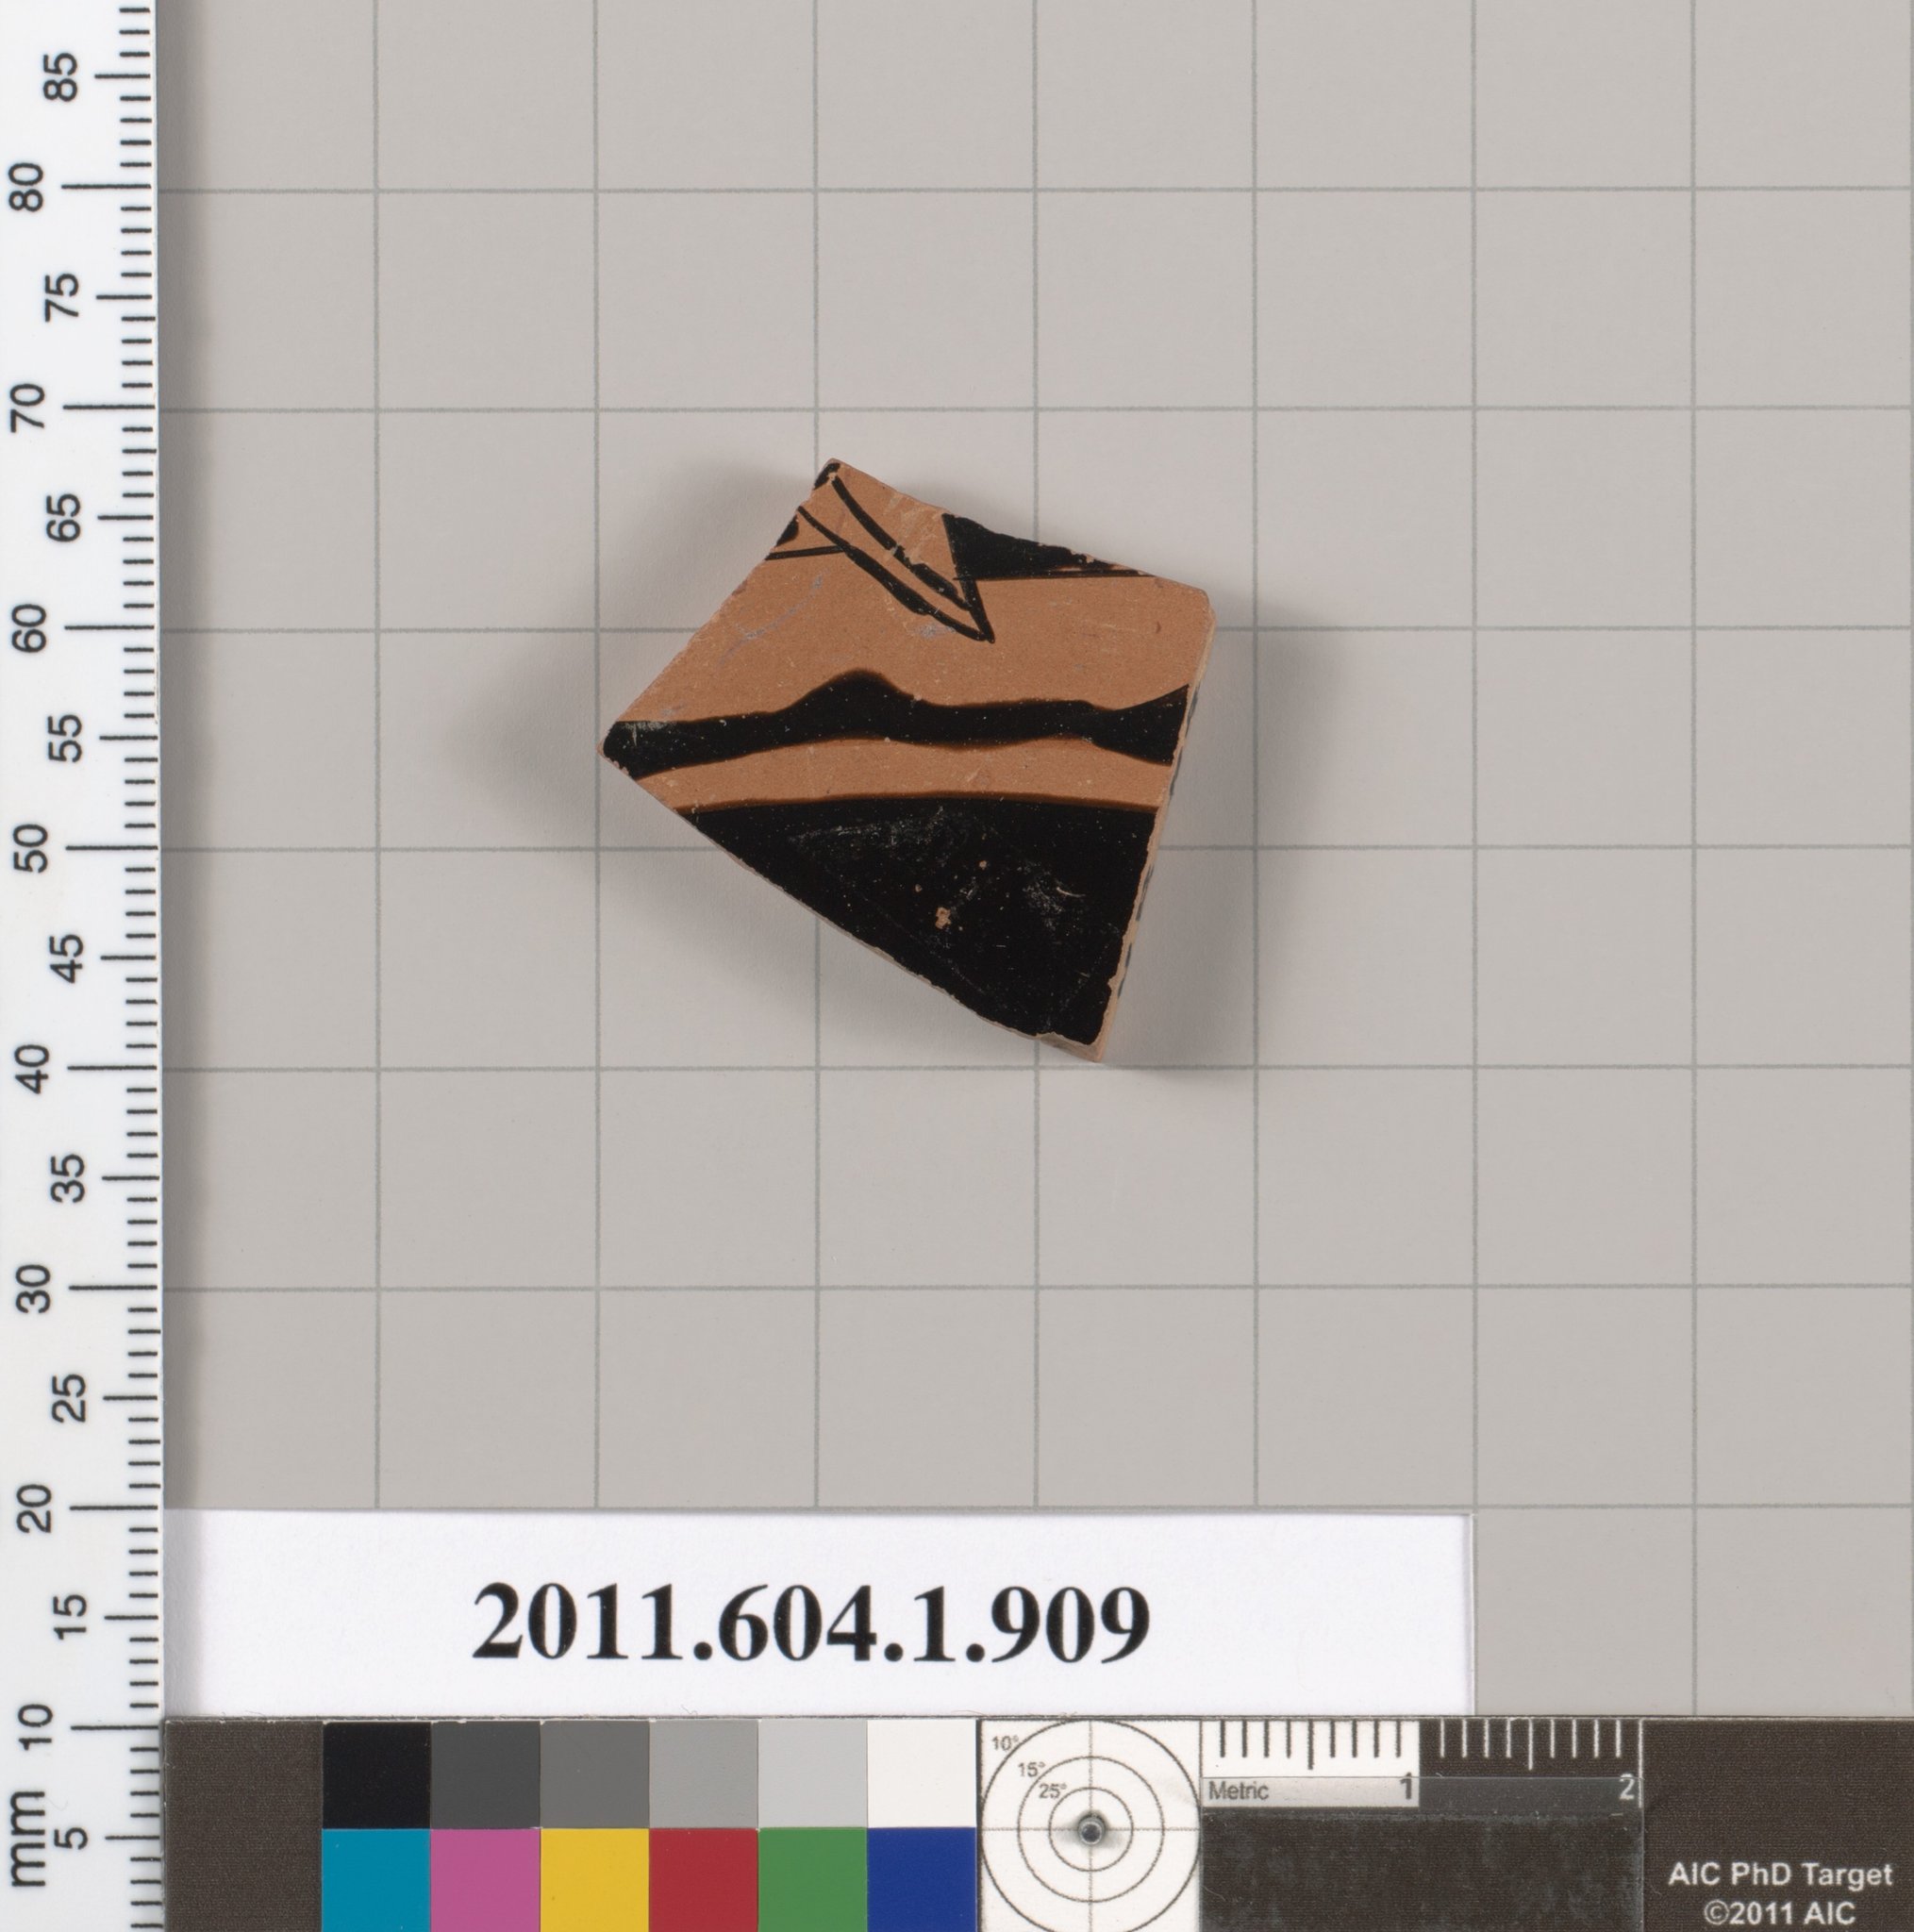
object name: kylix fragment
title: Terracotta fragment of a kylix (drinking cup)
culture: greek, attic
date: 475-451 BCE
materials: terracotta